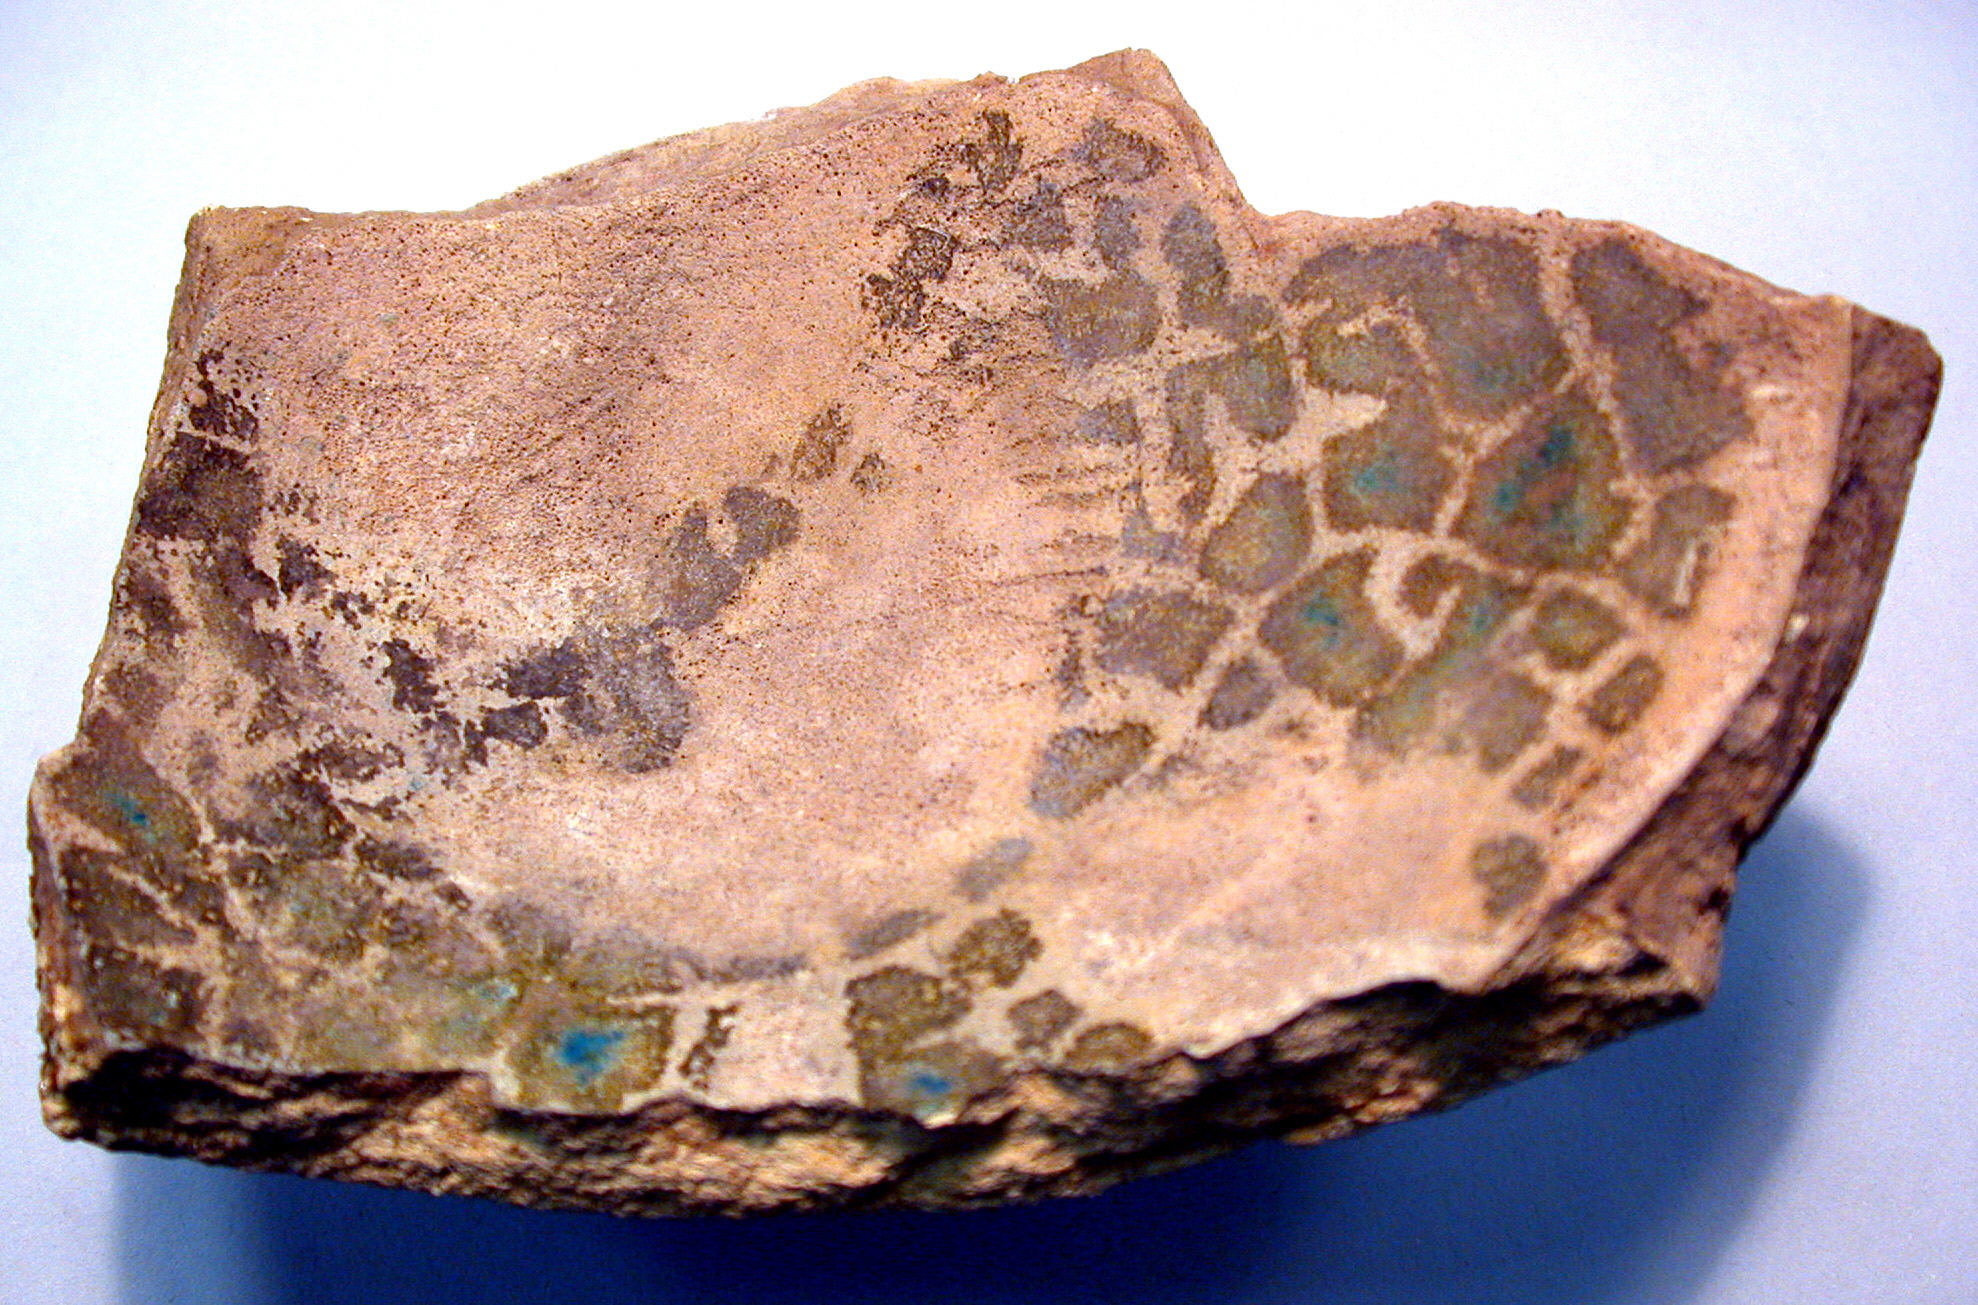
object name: vessel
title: Fragment of a vessel base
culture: sasanian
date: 201-700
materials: ceramic, glaze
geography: mesopotamia